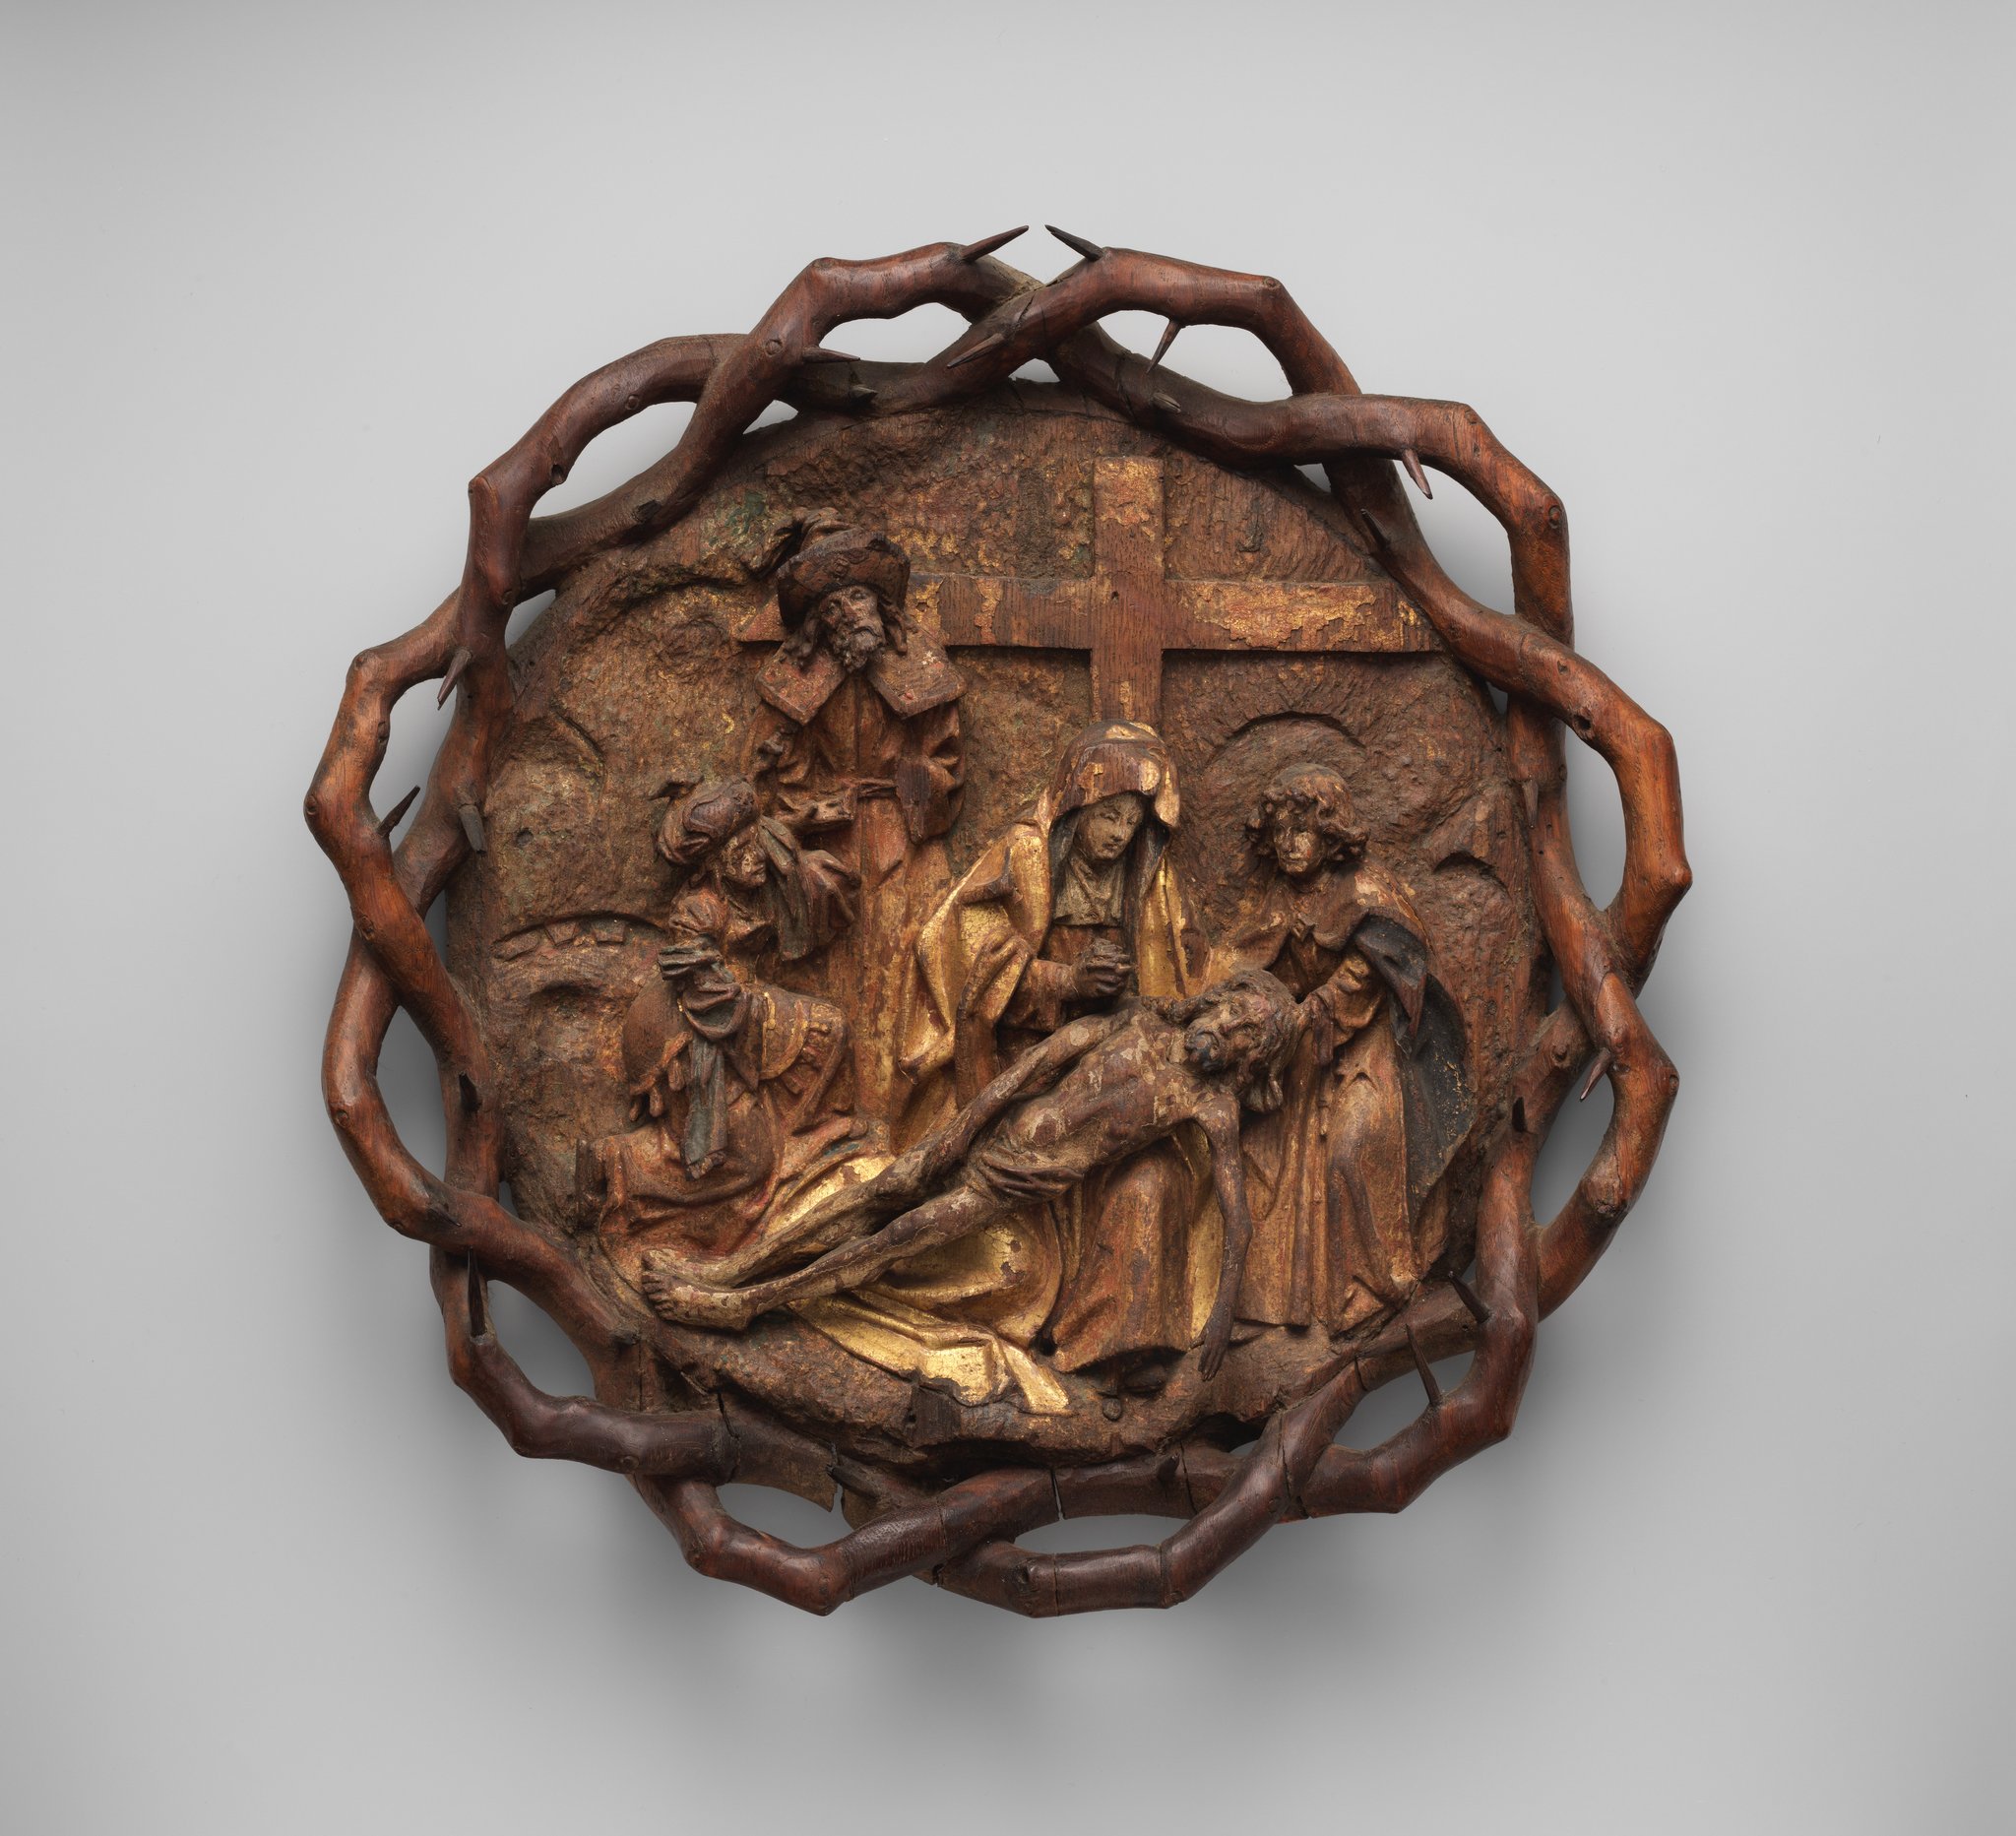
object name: relief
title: The Crown of Thorns with the Lamentation or Pietà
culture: french or south netherlandish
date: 1501-1600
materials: wood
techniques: gilding, painting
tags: christ,virgin mary,cross